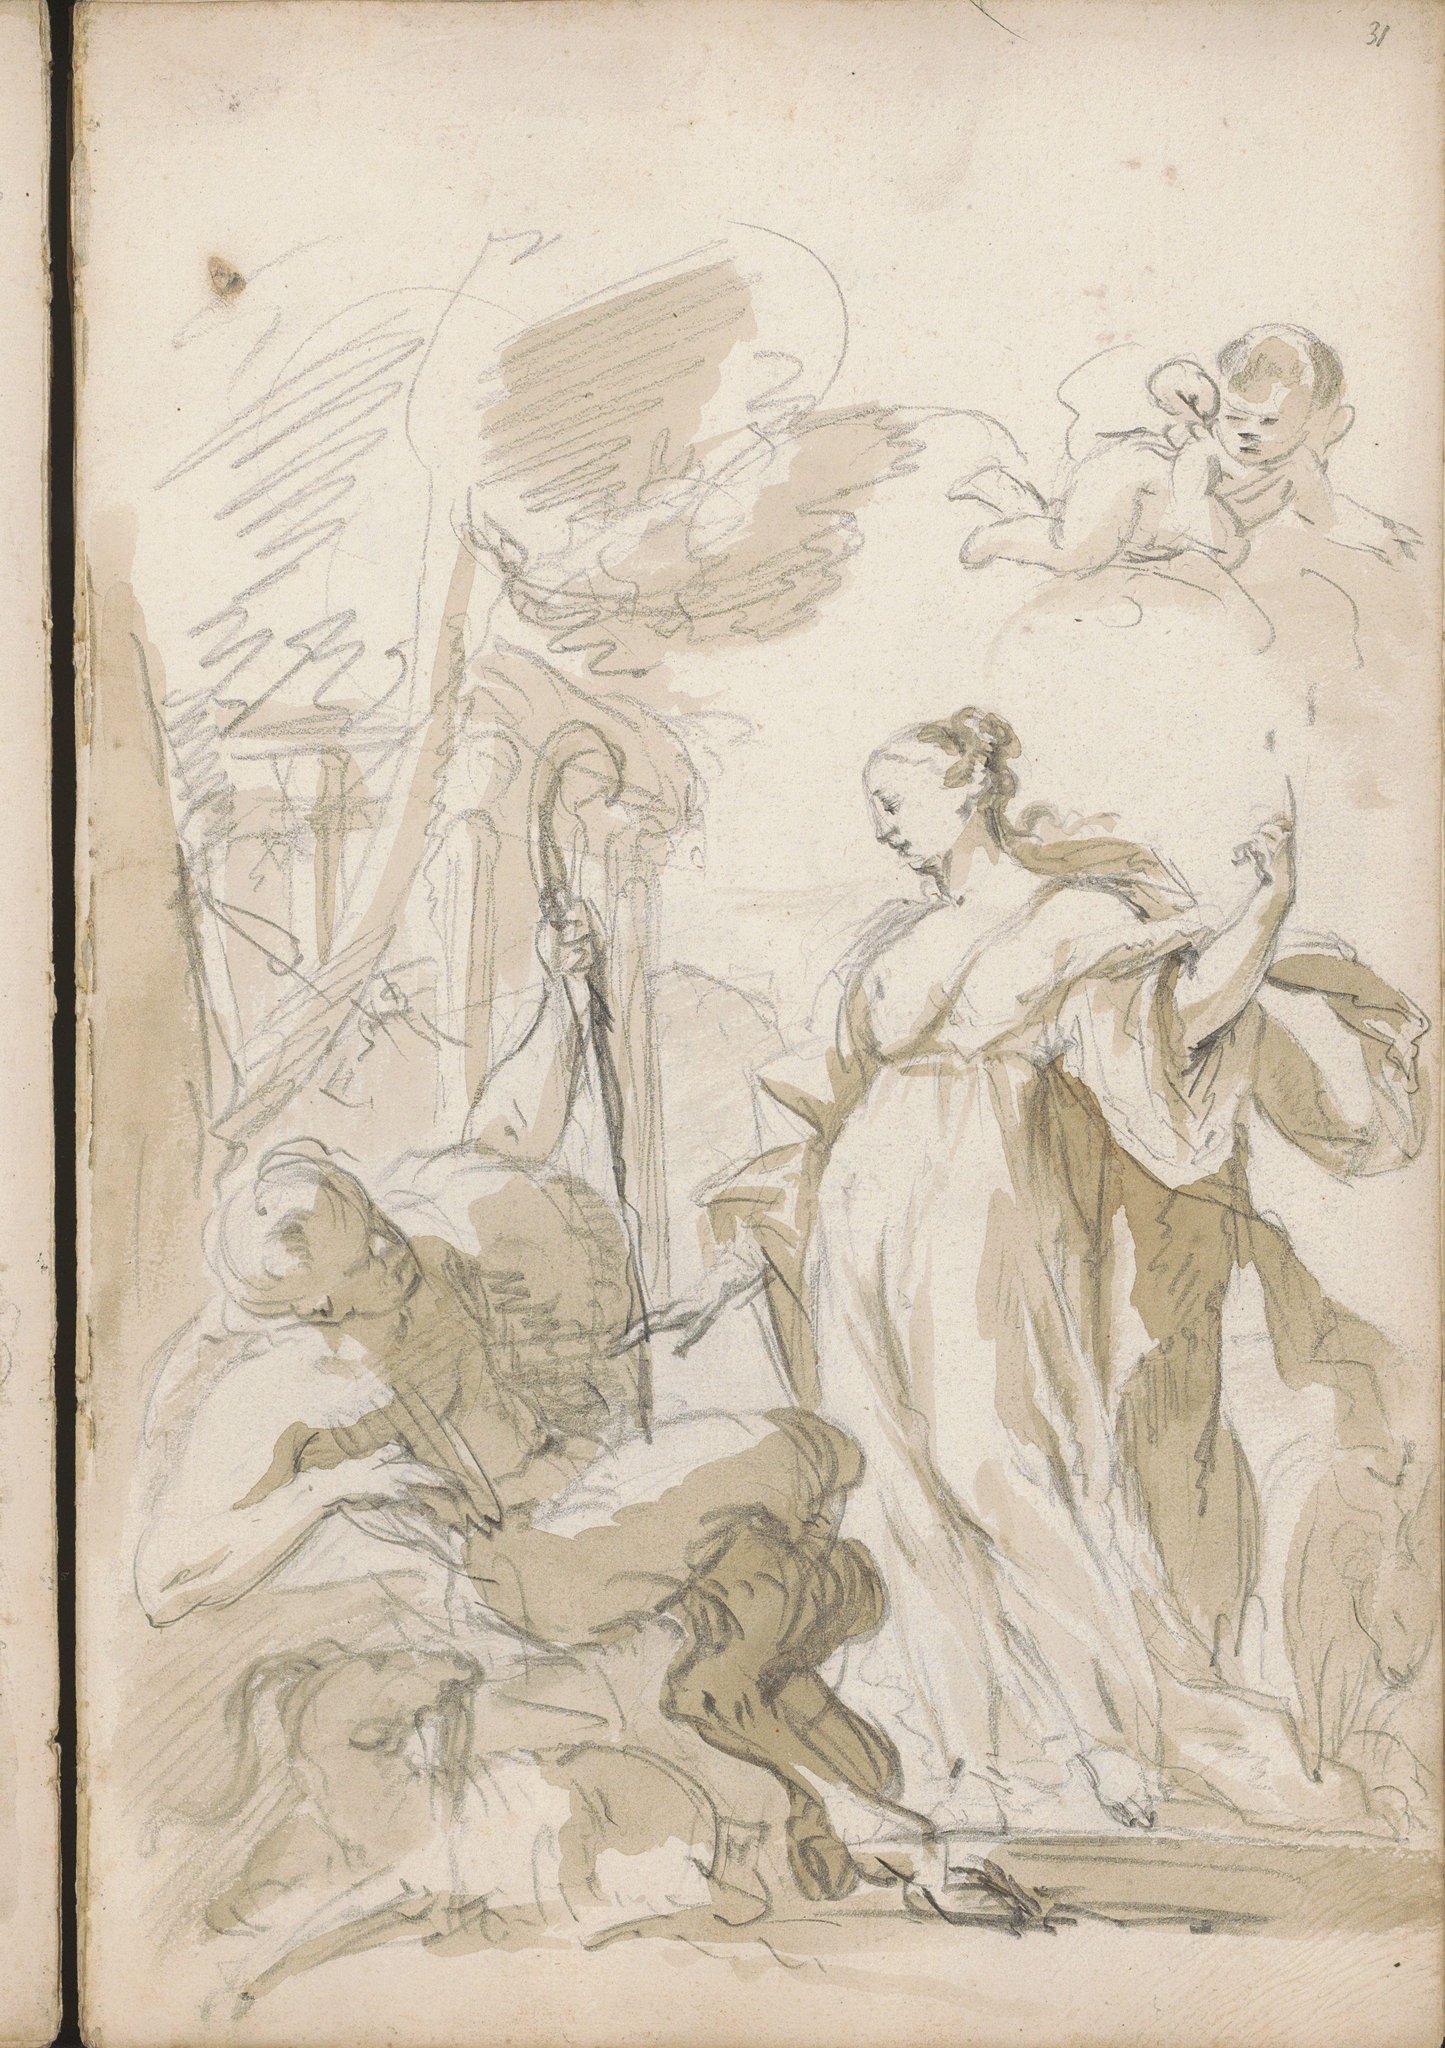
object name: sketchbook leaf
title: Man met staf en bokkenpoten zittend voor een vrouw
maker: Anonymous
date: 1650-1799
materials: ink, paper, pencil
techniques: brush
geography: italy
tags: satyr(s) (in general), cupids: 'amores', 'amoretti', 'putti', index finger forwards, pointing, indicating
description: De man, mogelijk een sater, leunt achterover. Naast hem ligt een geit. De vrouw houdt haar linkerhand opgeheven en wijst naar de hemel. Boven haar vliegt een putto en op de achtergrond is een tempel te zien. Bladzijde 31 uit een schetsboek met 72 bladzijden.